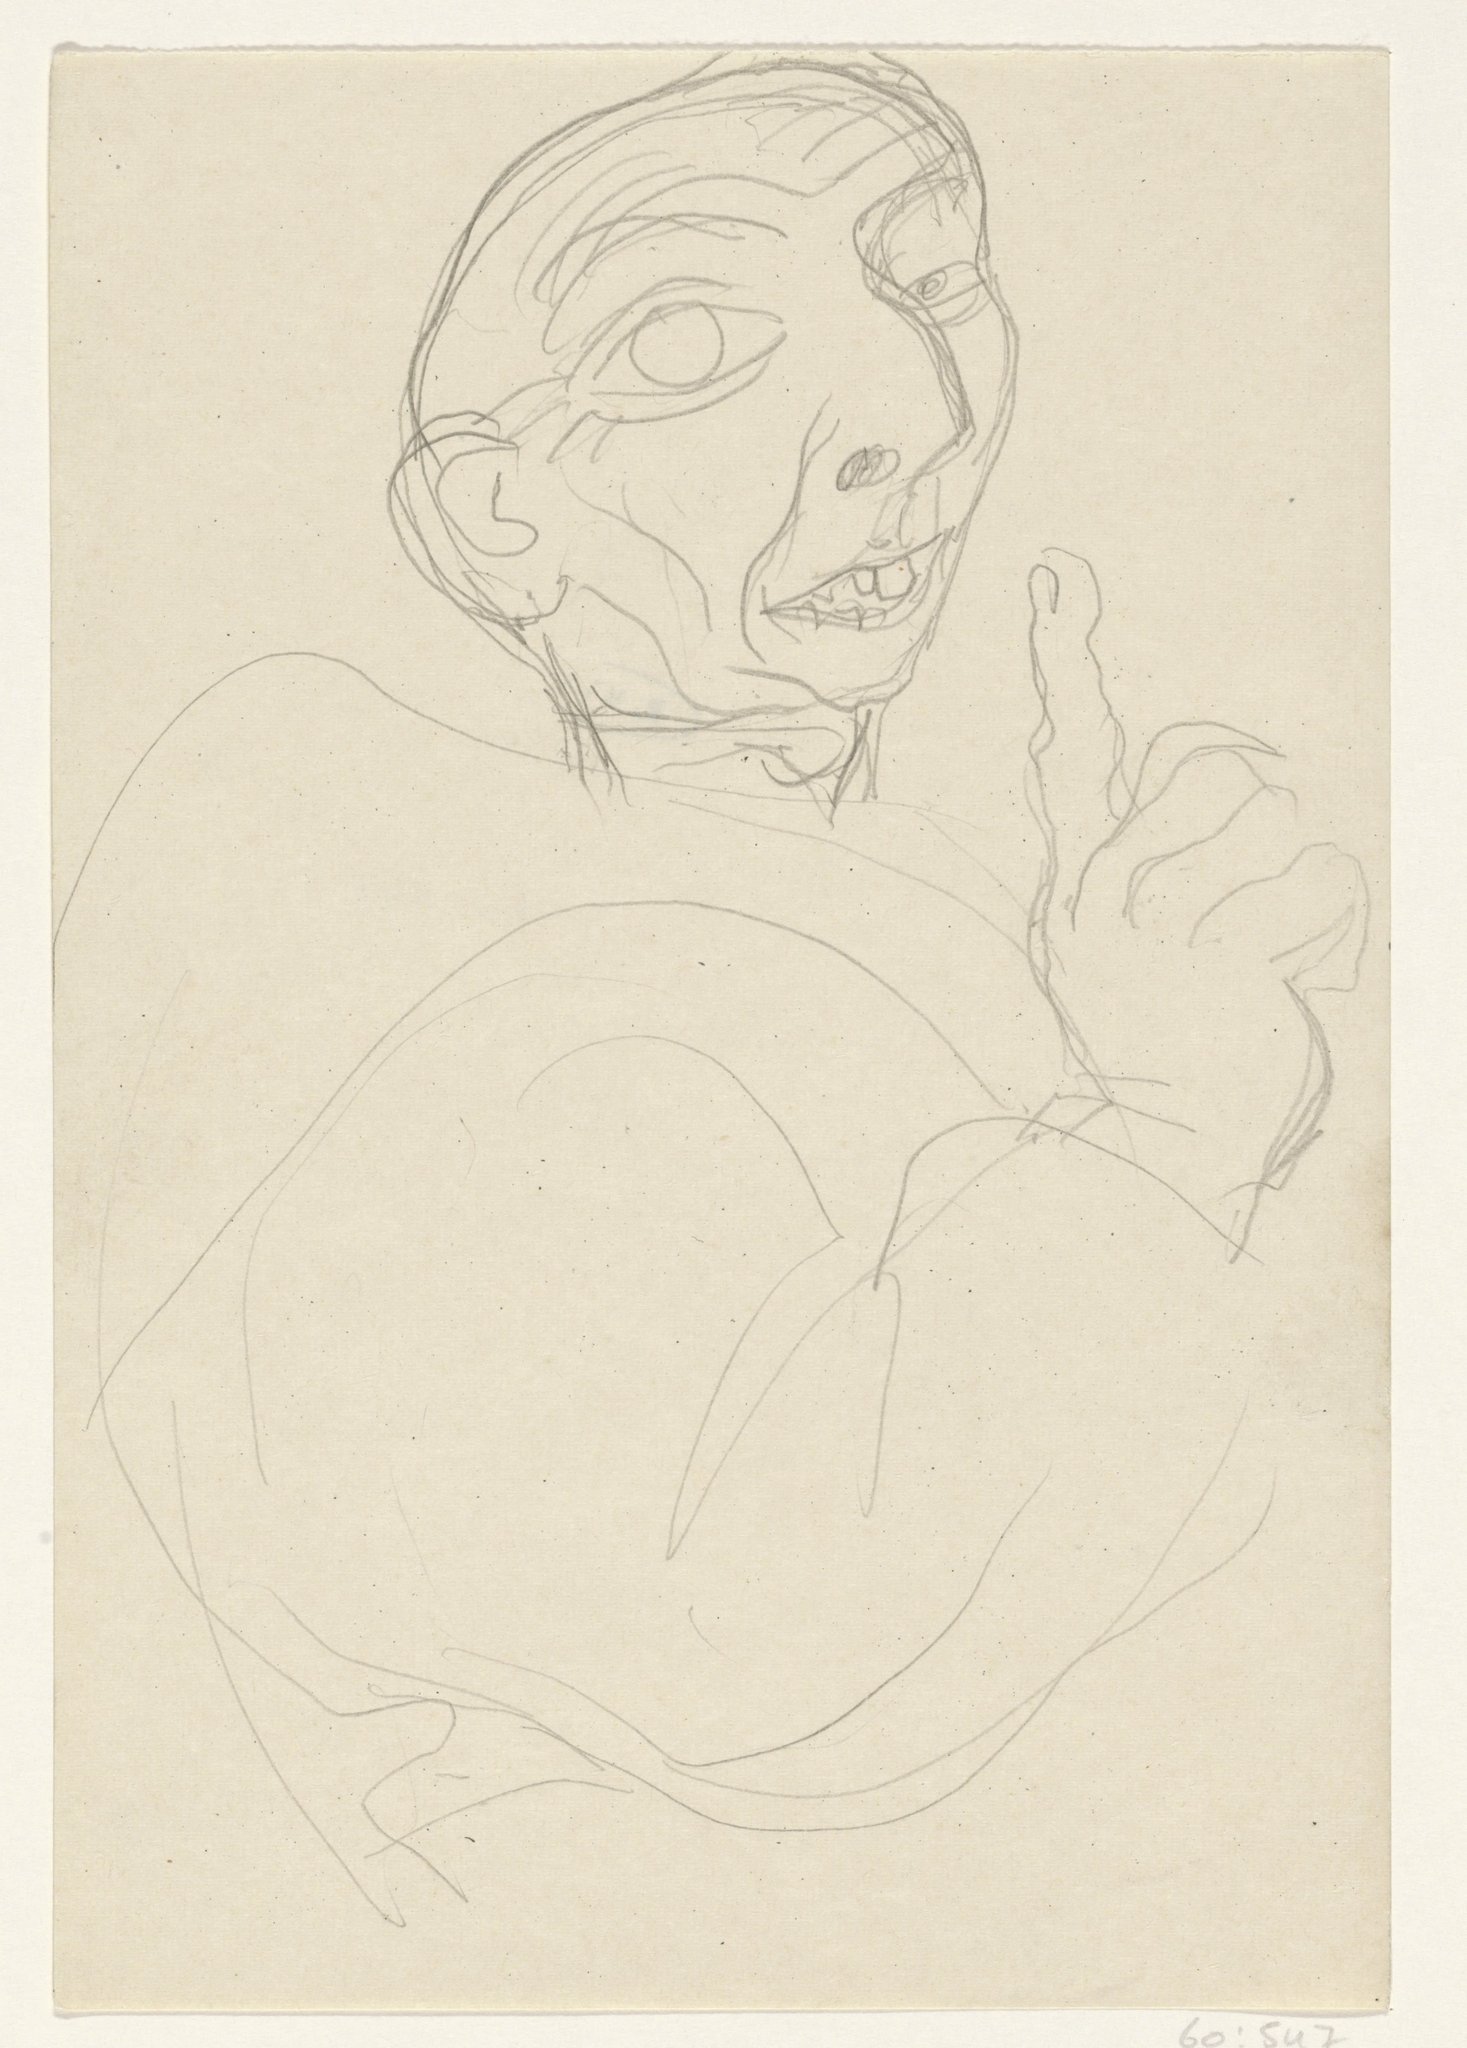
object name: drawing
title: Karikatuur van Leo Gestel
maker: leo gestel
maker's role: draughtsman, print maker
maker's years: 1881-1941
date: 1891-1941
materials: paper, pencil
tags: draughtsman, leo gestel, historical persons, portrait, self-portrait of artist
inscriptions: collector's mark: Lugt 2228